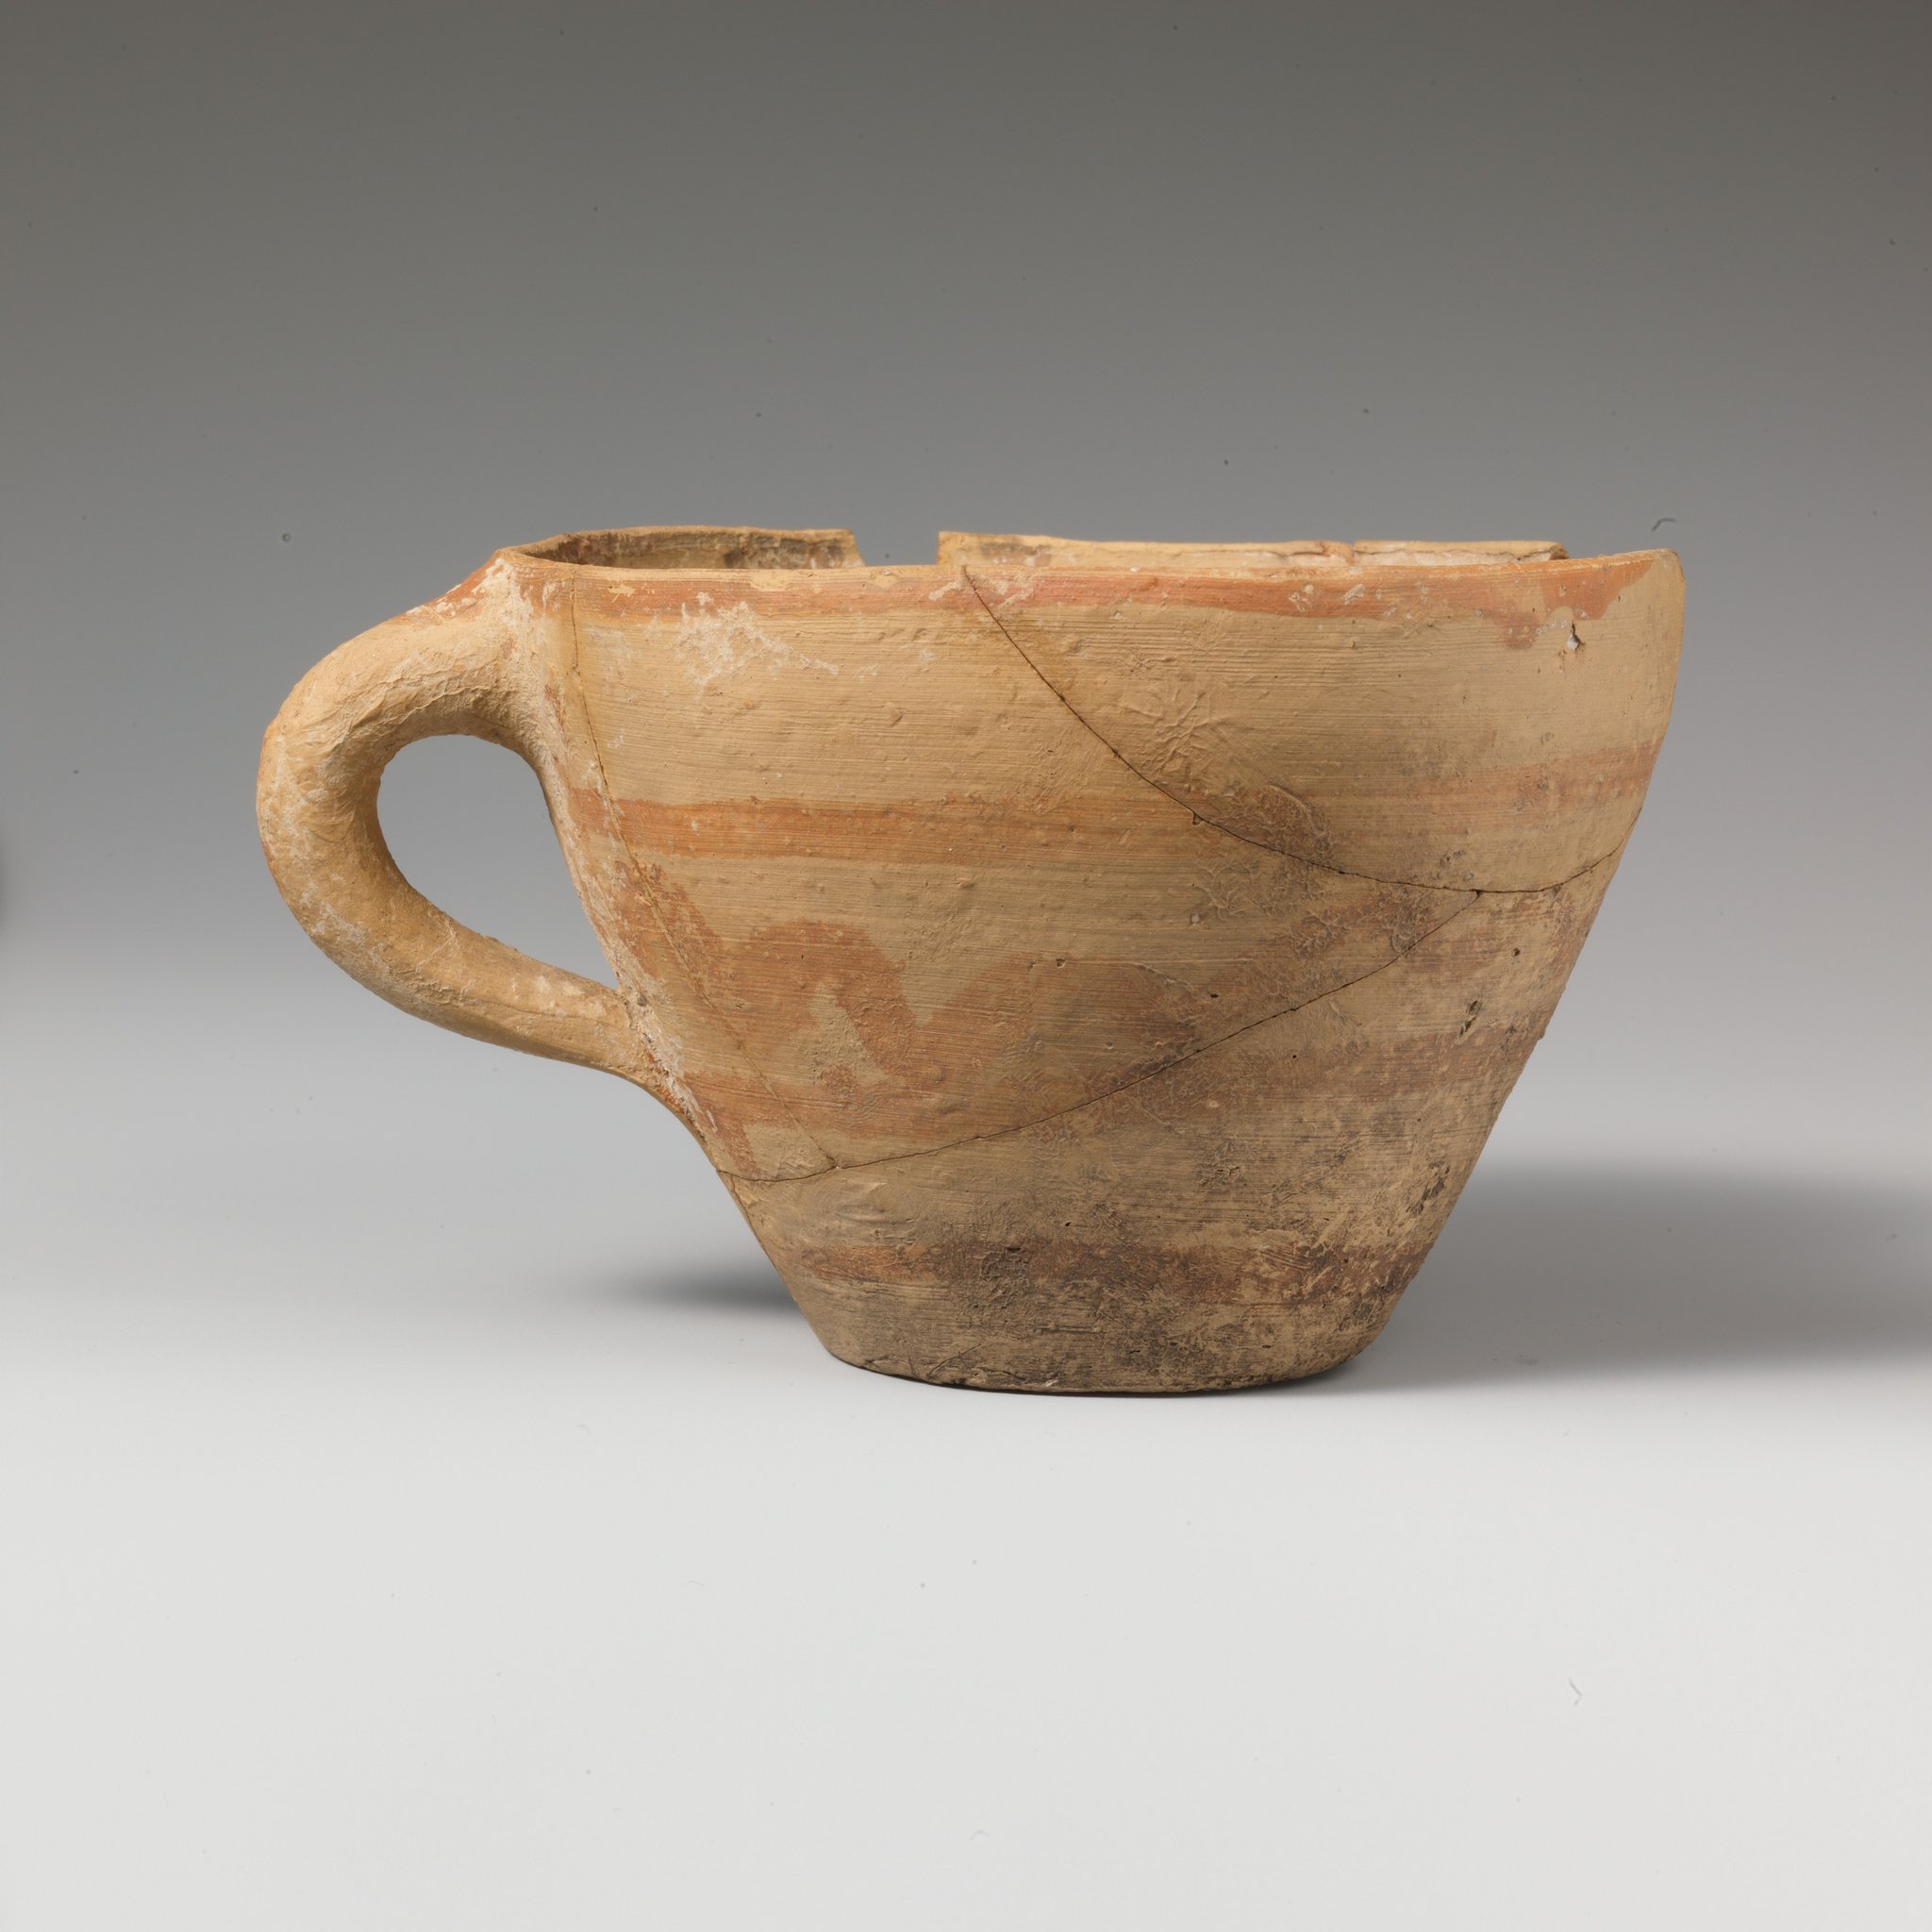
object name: cup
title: Terracotta one-handled cup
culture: minoan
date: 1600-1450 BCE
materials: terracotta